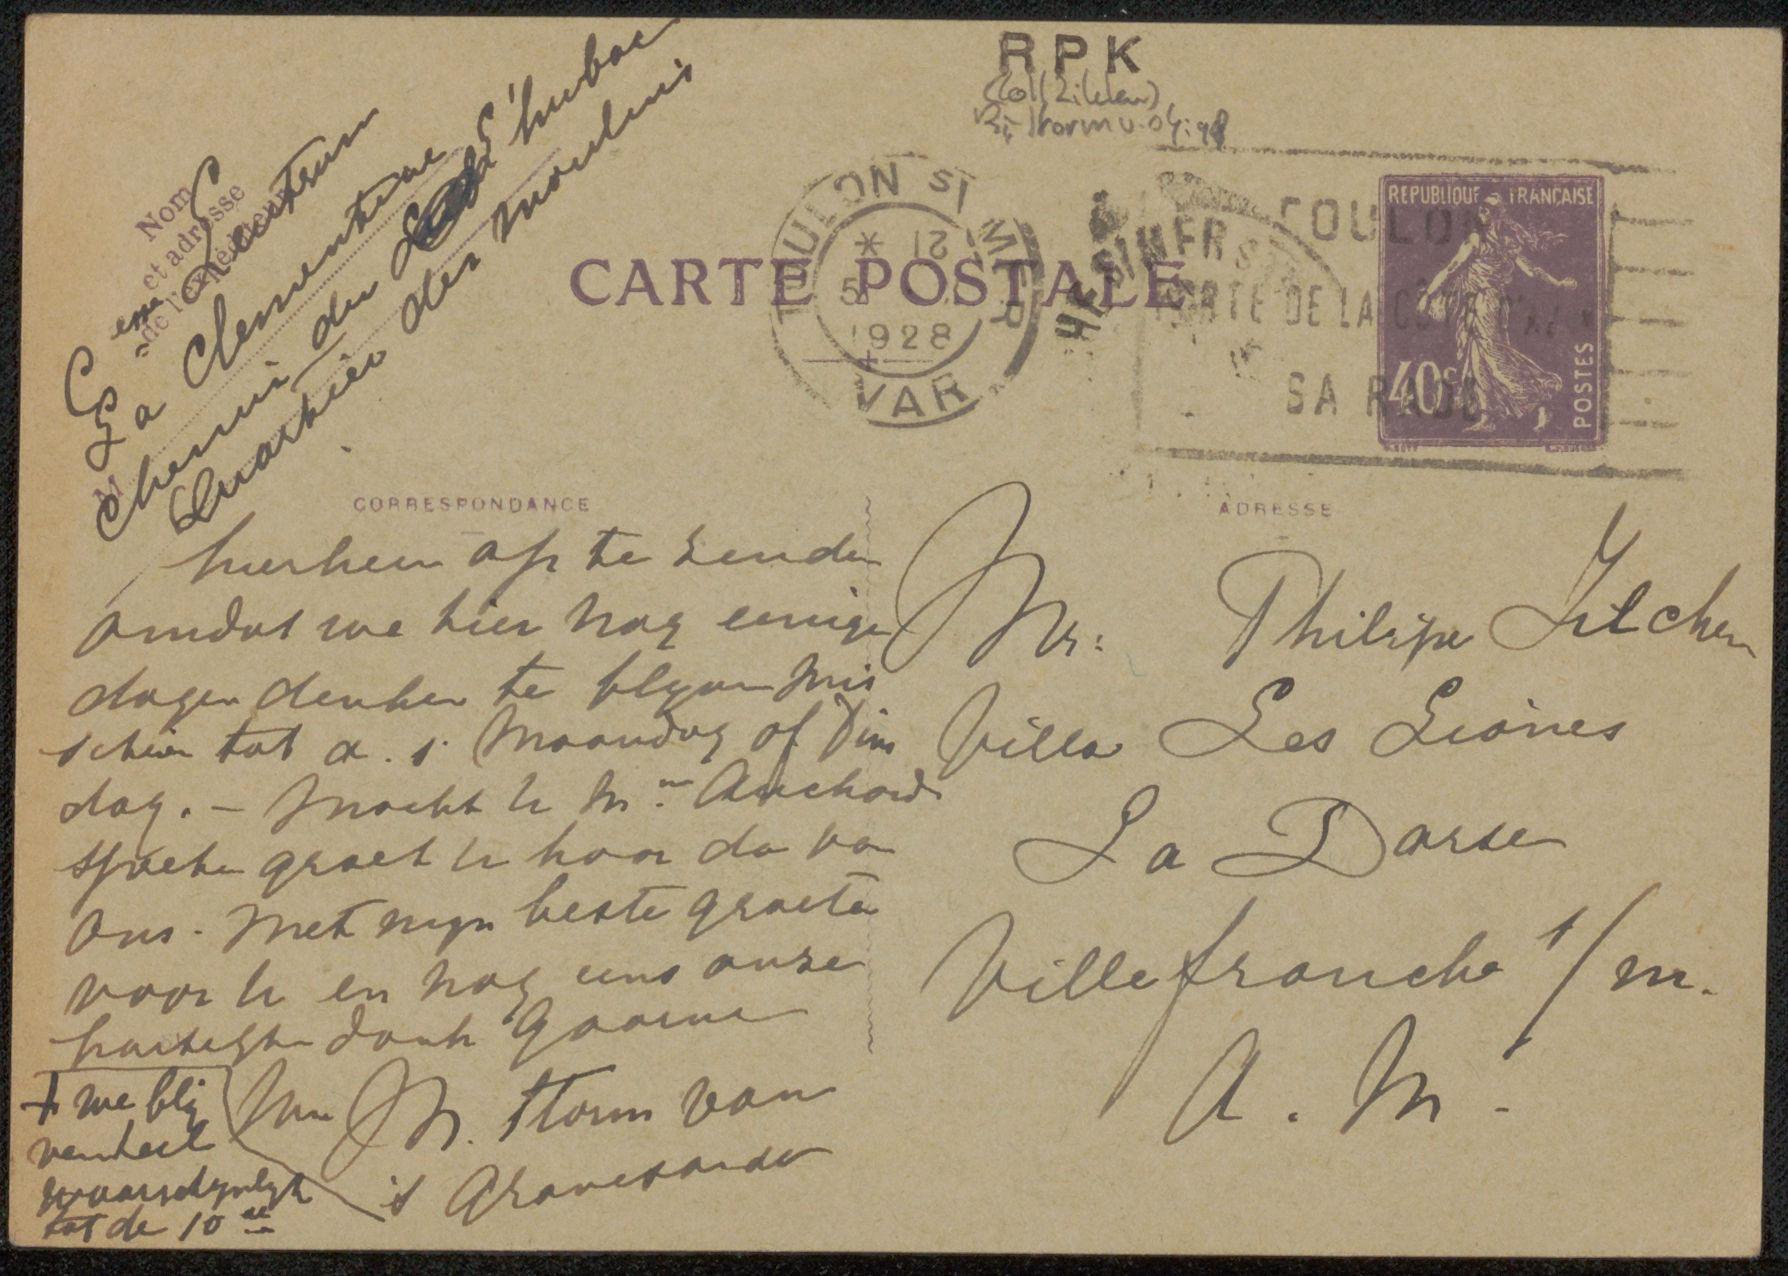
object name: postcard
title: Briefkaart aan Philip Zilcken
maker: carel nicolaas storm van s-gravesande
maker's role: draughtsman, print maker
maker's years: 1841-1924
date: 1928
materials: cardboard, ink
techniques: pen, writing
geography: toulon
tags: painter, philip zilcken, toulon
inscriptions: collector's mark: ‘RPK’